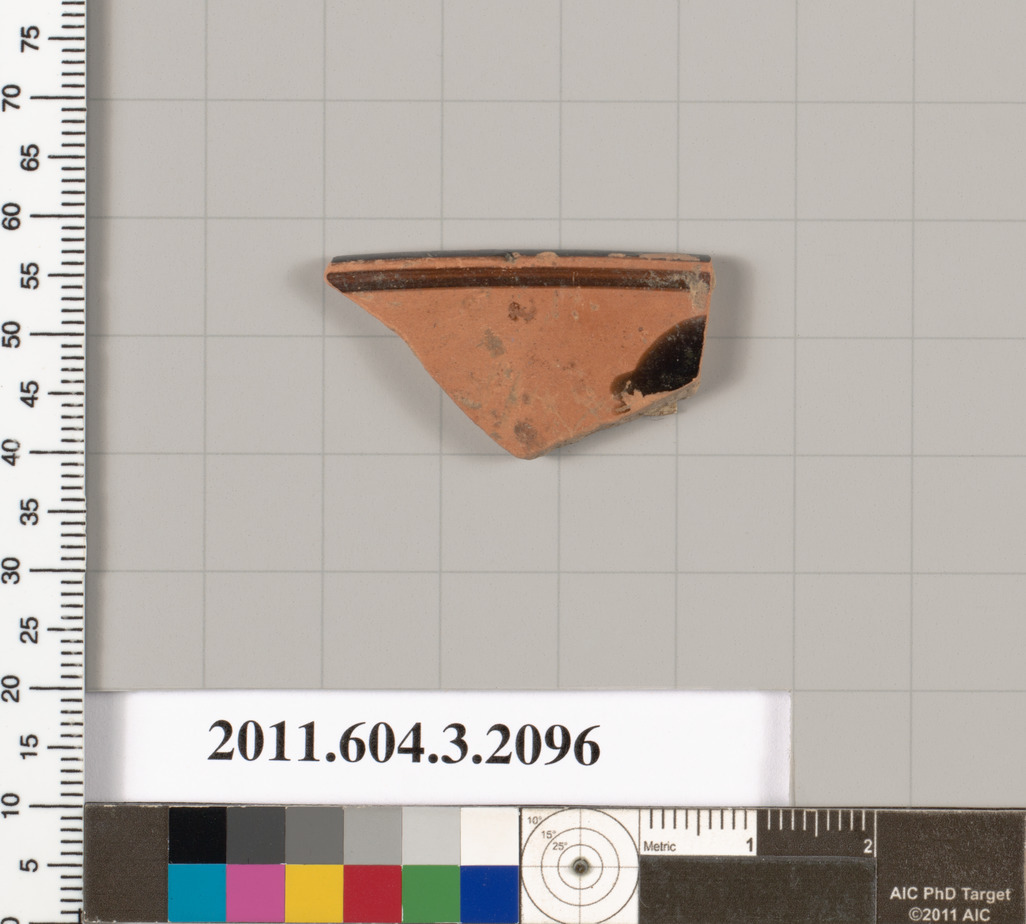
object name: kylix fragment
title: Terracotta rim fragment of a kylix (drinking cup)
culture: greek, attic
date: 534-468 BCE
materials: terracotta